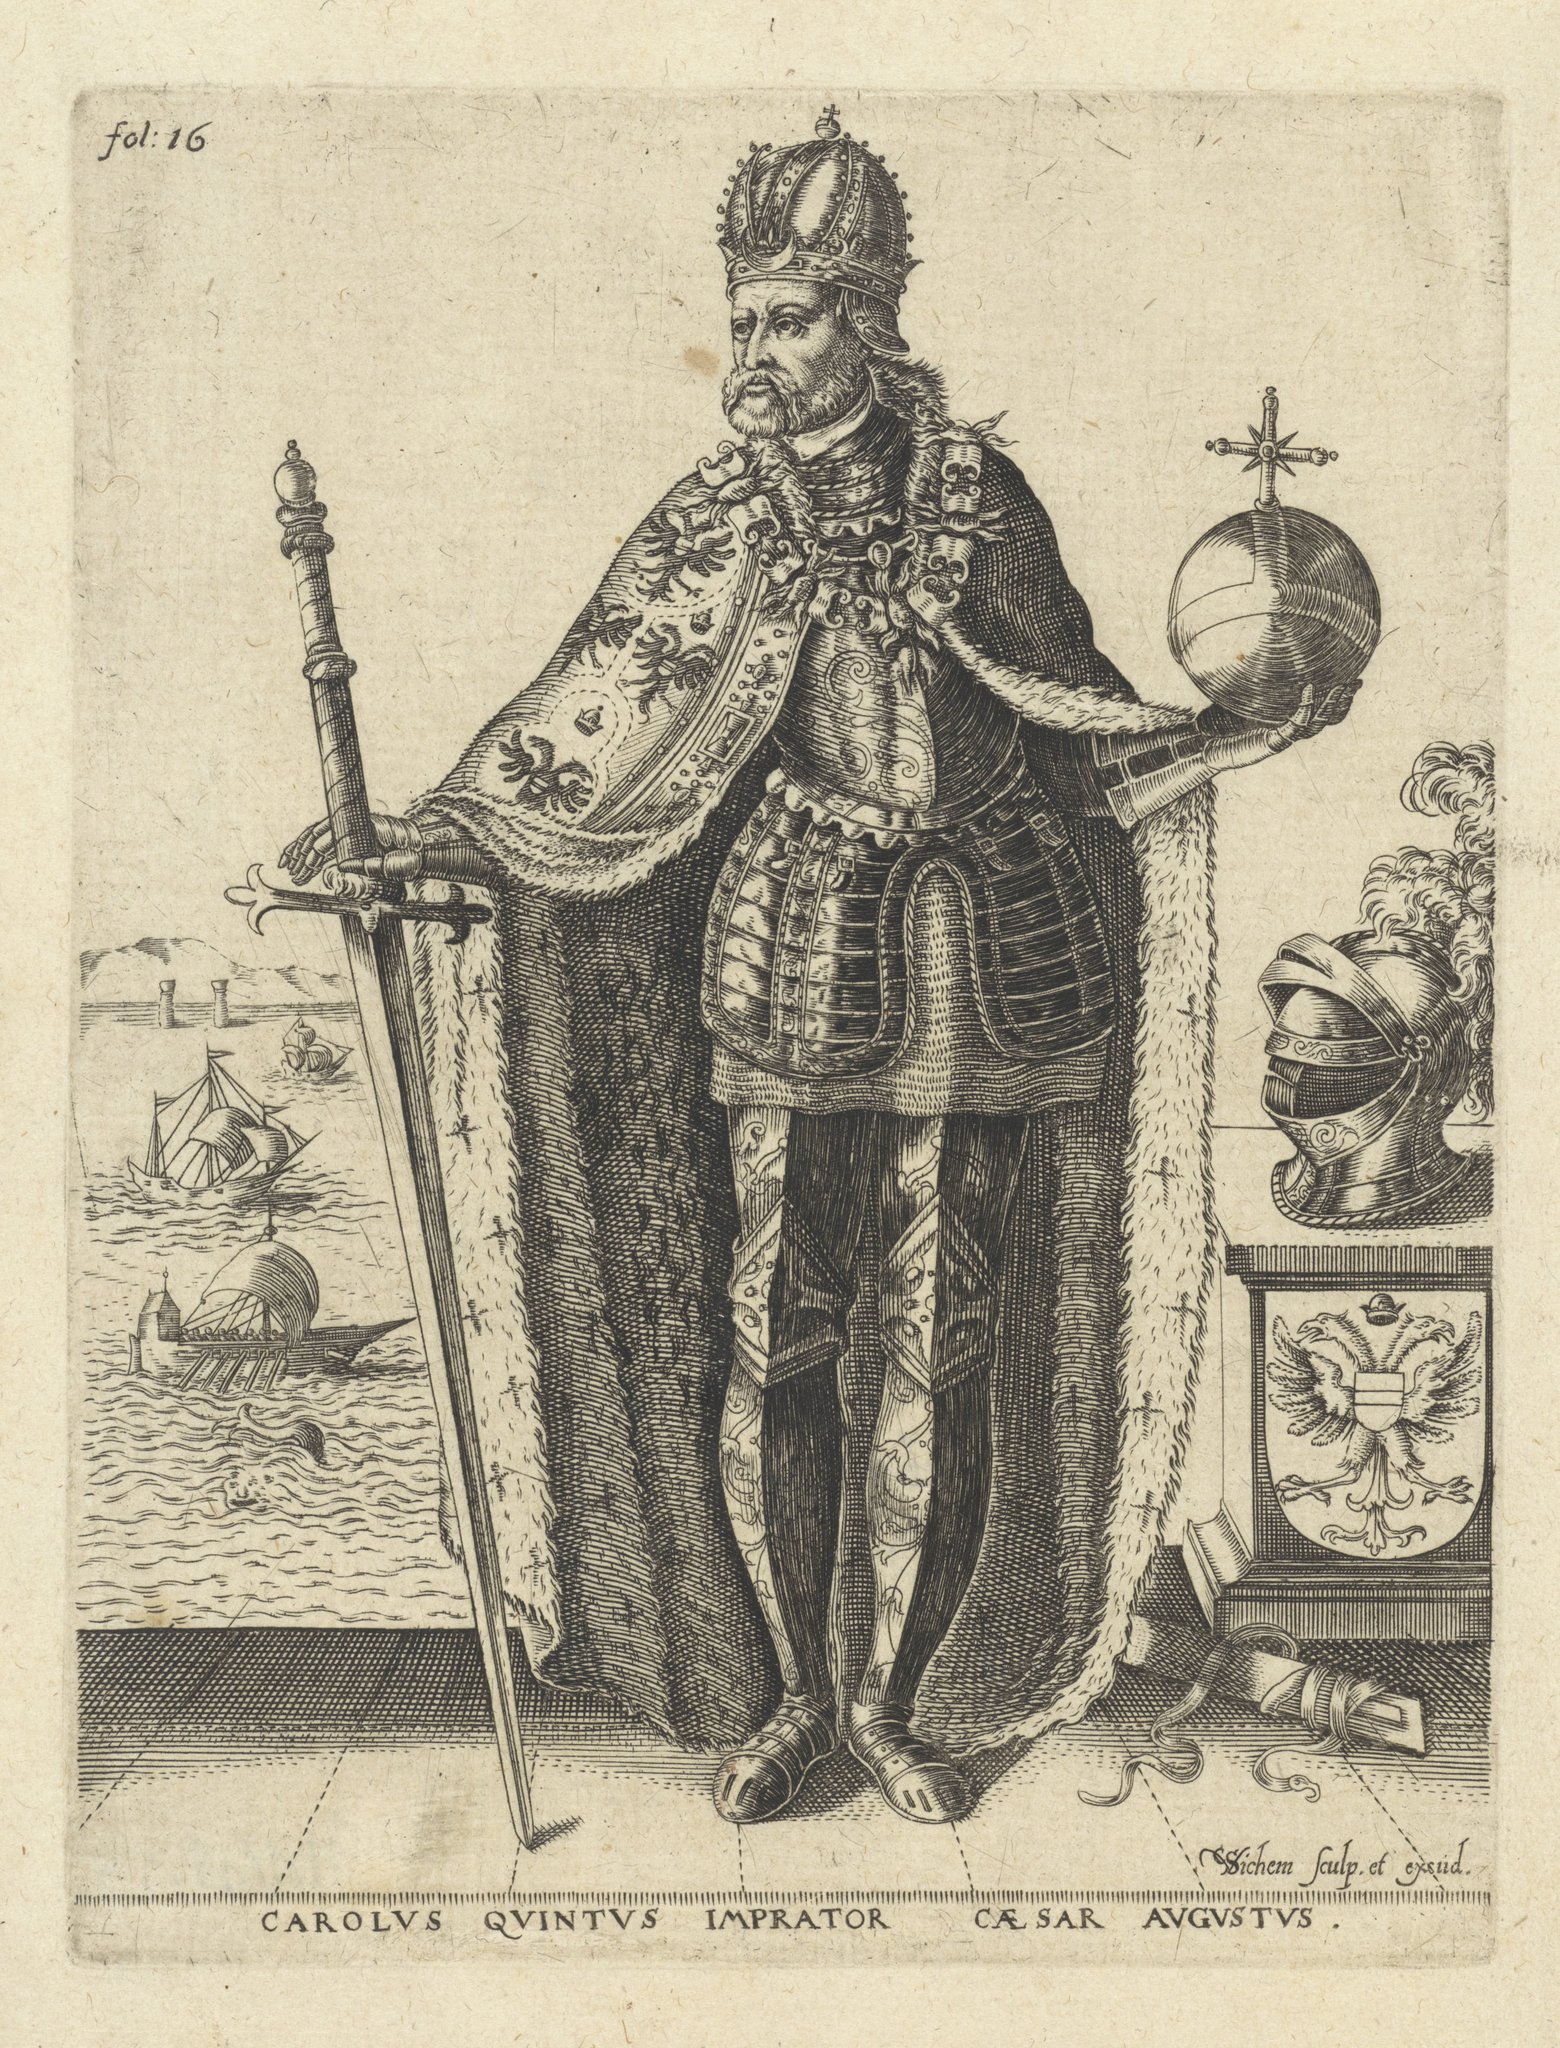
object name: book illustration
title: Carolus Quintus Imprator[sic!] Caesar Augustus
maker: christoffel van sichem (i)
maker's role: print maker, publisher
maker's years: 1546-1624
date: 1611-1663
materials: paper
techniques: engraving, etching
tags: ghent, charles v (holy roman emperor and king of spain)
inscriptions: collector's mark: Lugt 2228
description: Portret van keizer Karel V, met kroon en rijk geborduurde, met bont gevoerde mantel. In de ene hand houdt hij een groot zwaard, in de andere een rijksappel. Hij staat naast een voetstuk, waarop de helm van zijn harnas ligt. Het voetstuk is gedecoreerd met zijn wapenschild. De achtergrond biedt zicht op zee, met schepen en een dolfijn. In de linkerbovenhoek: fol: 16.